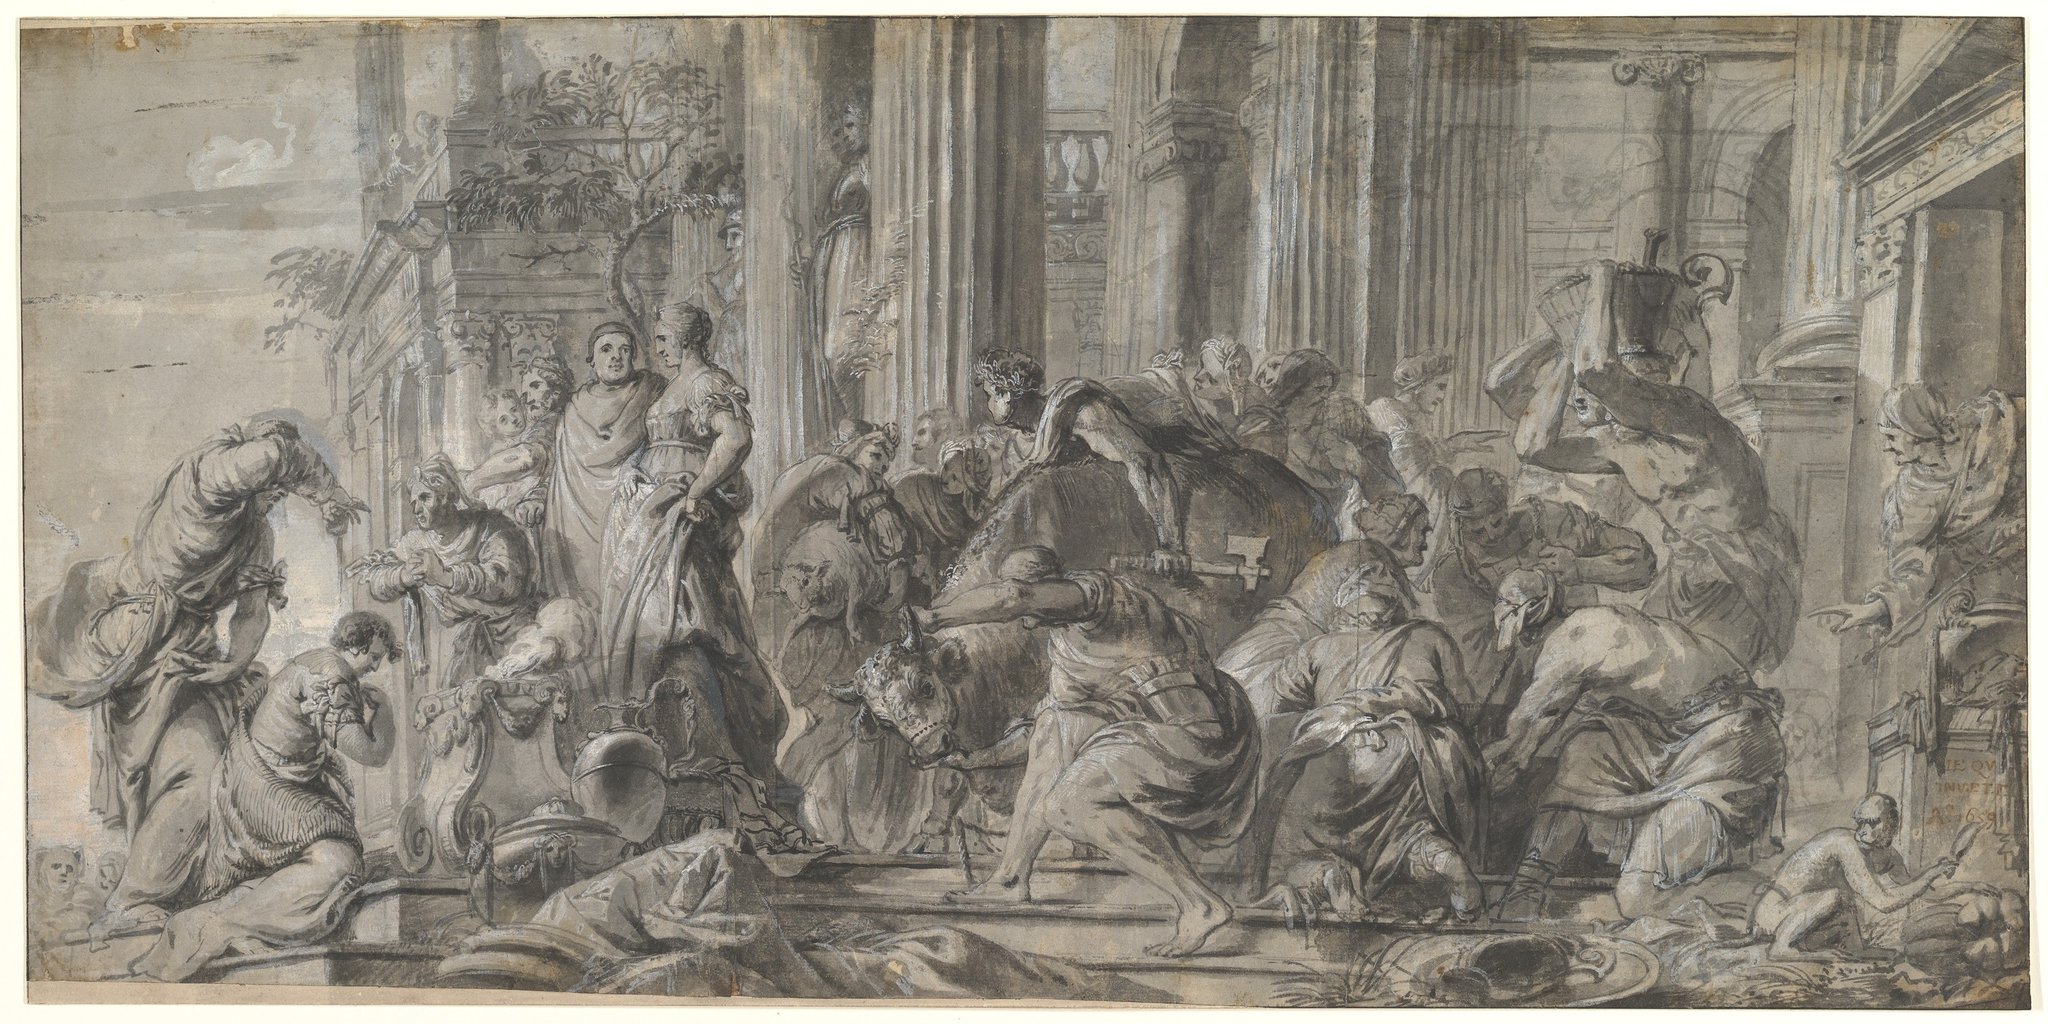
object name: drawing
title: Samuel Anointing the Young David (?)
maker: jan erasmus quellinus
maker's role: artist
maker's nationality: flemish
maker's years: 1634-1715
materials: chalk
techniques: brush, heightening, wash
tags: animals,men,women,crowd